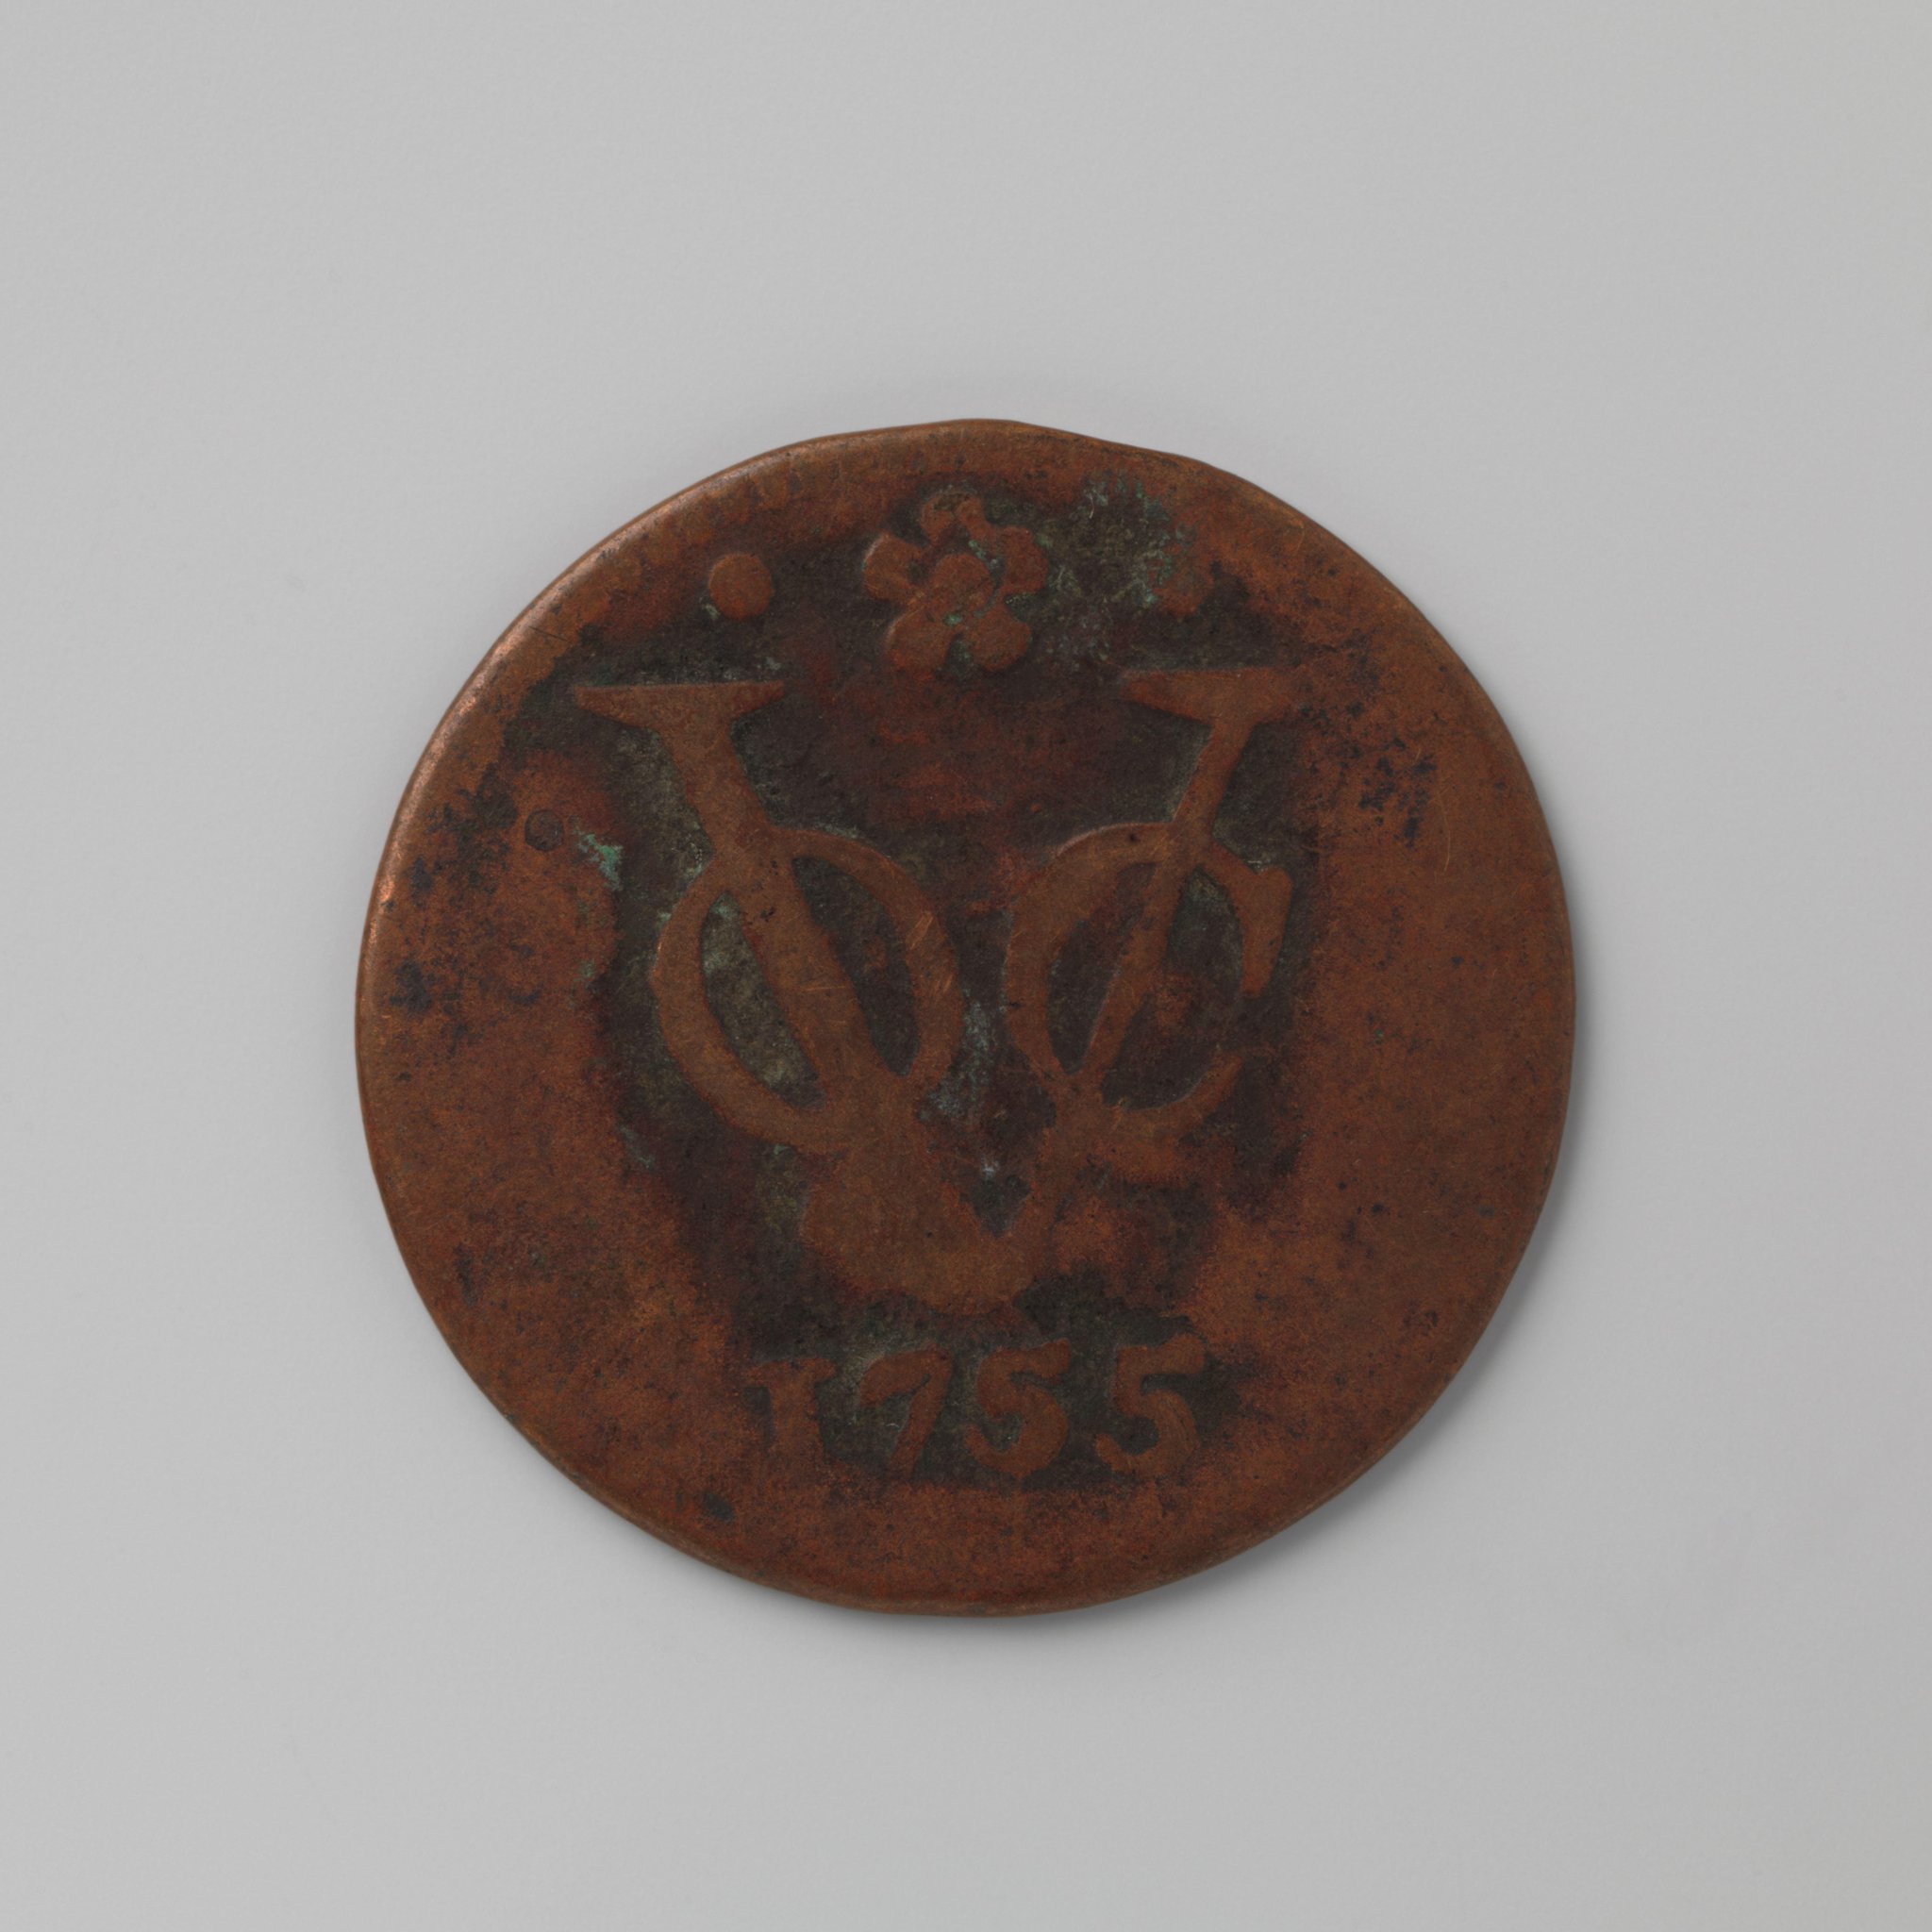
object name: coin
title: Duit van de VOC uit Holland, 1755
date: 1755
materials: copper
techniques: striking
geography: dordrecht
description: Koperen munt. Voorzijde: gekroond wapenschild van Holland. Keerzijde: monogram van de VOC, waarboven muntteken en waaronder jaartal. Gladde rand.